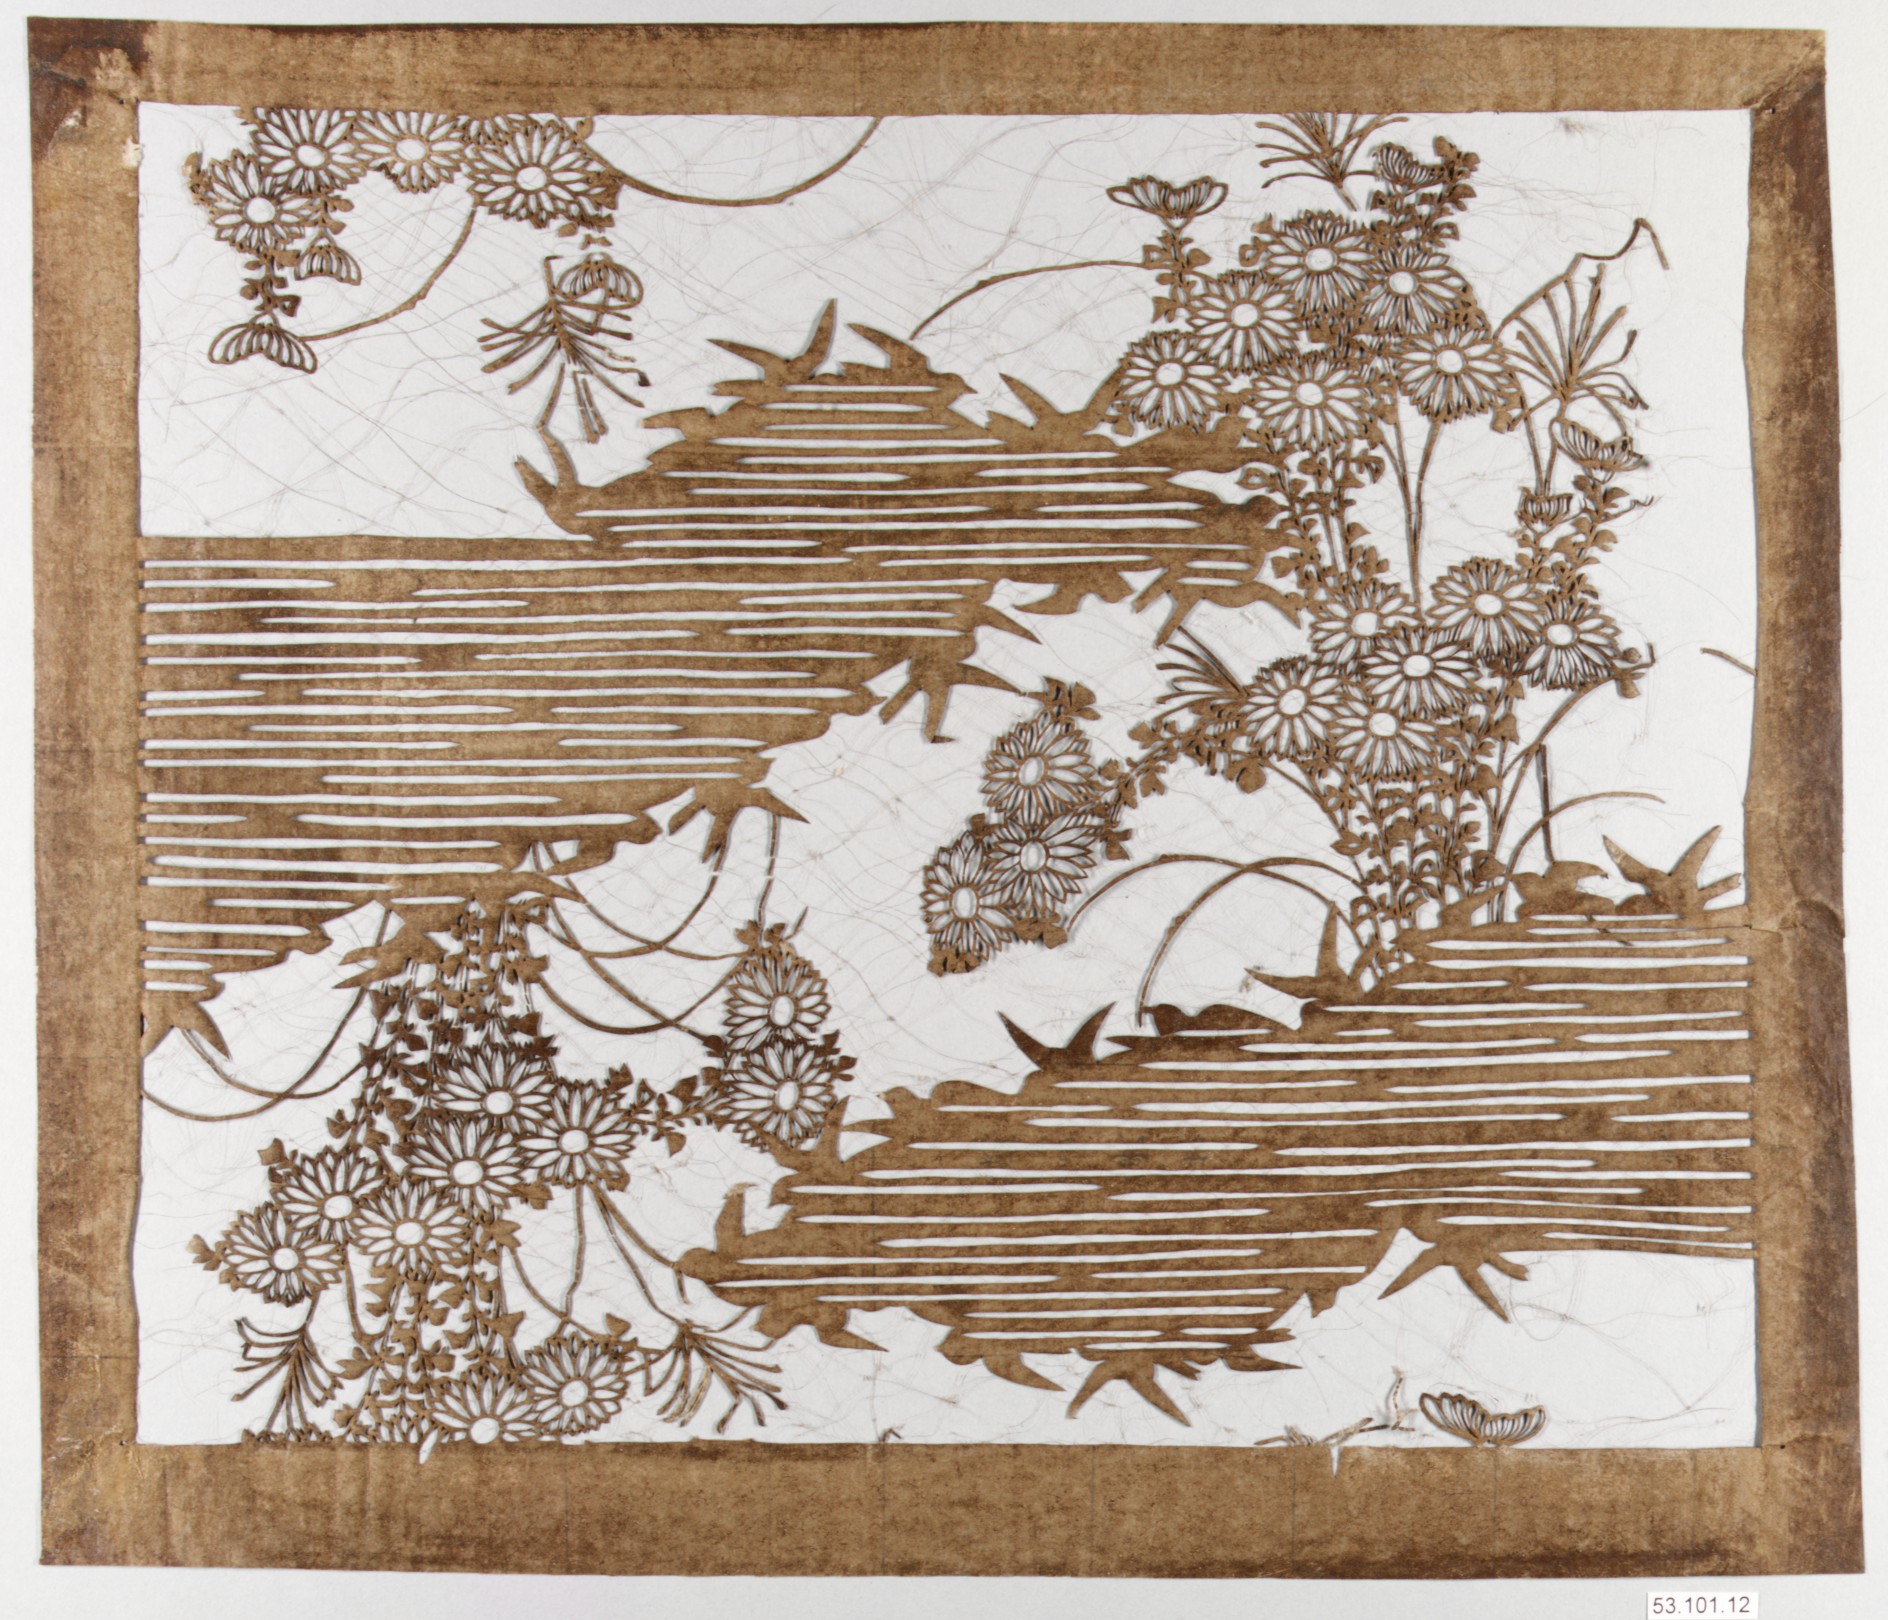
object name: stencil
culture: japanese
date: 1615-1868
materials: paper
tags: flowers